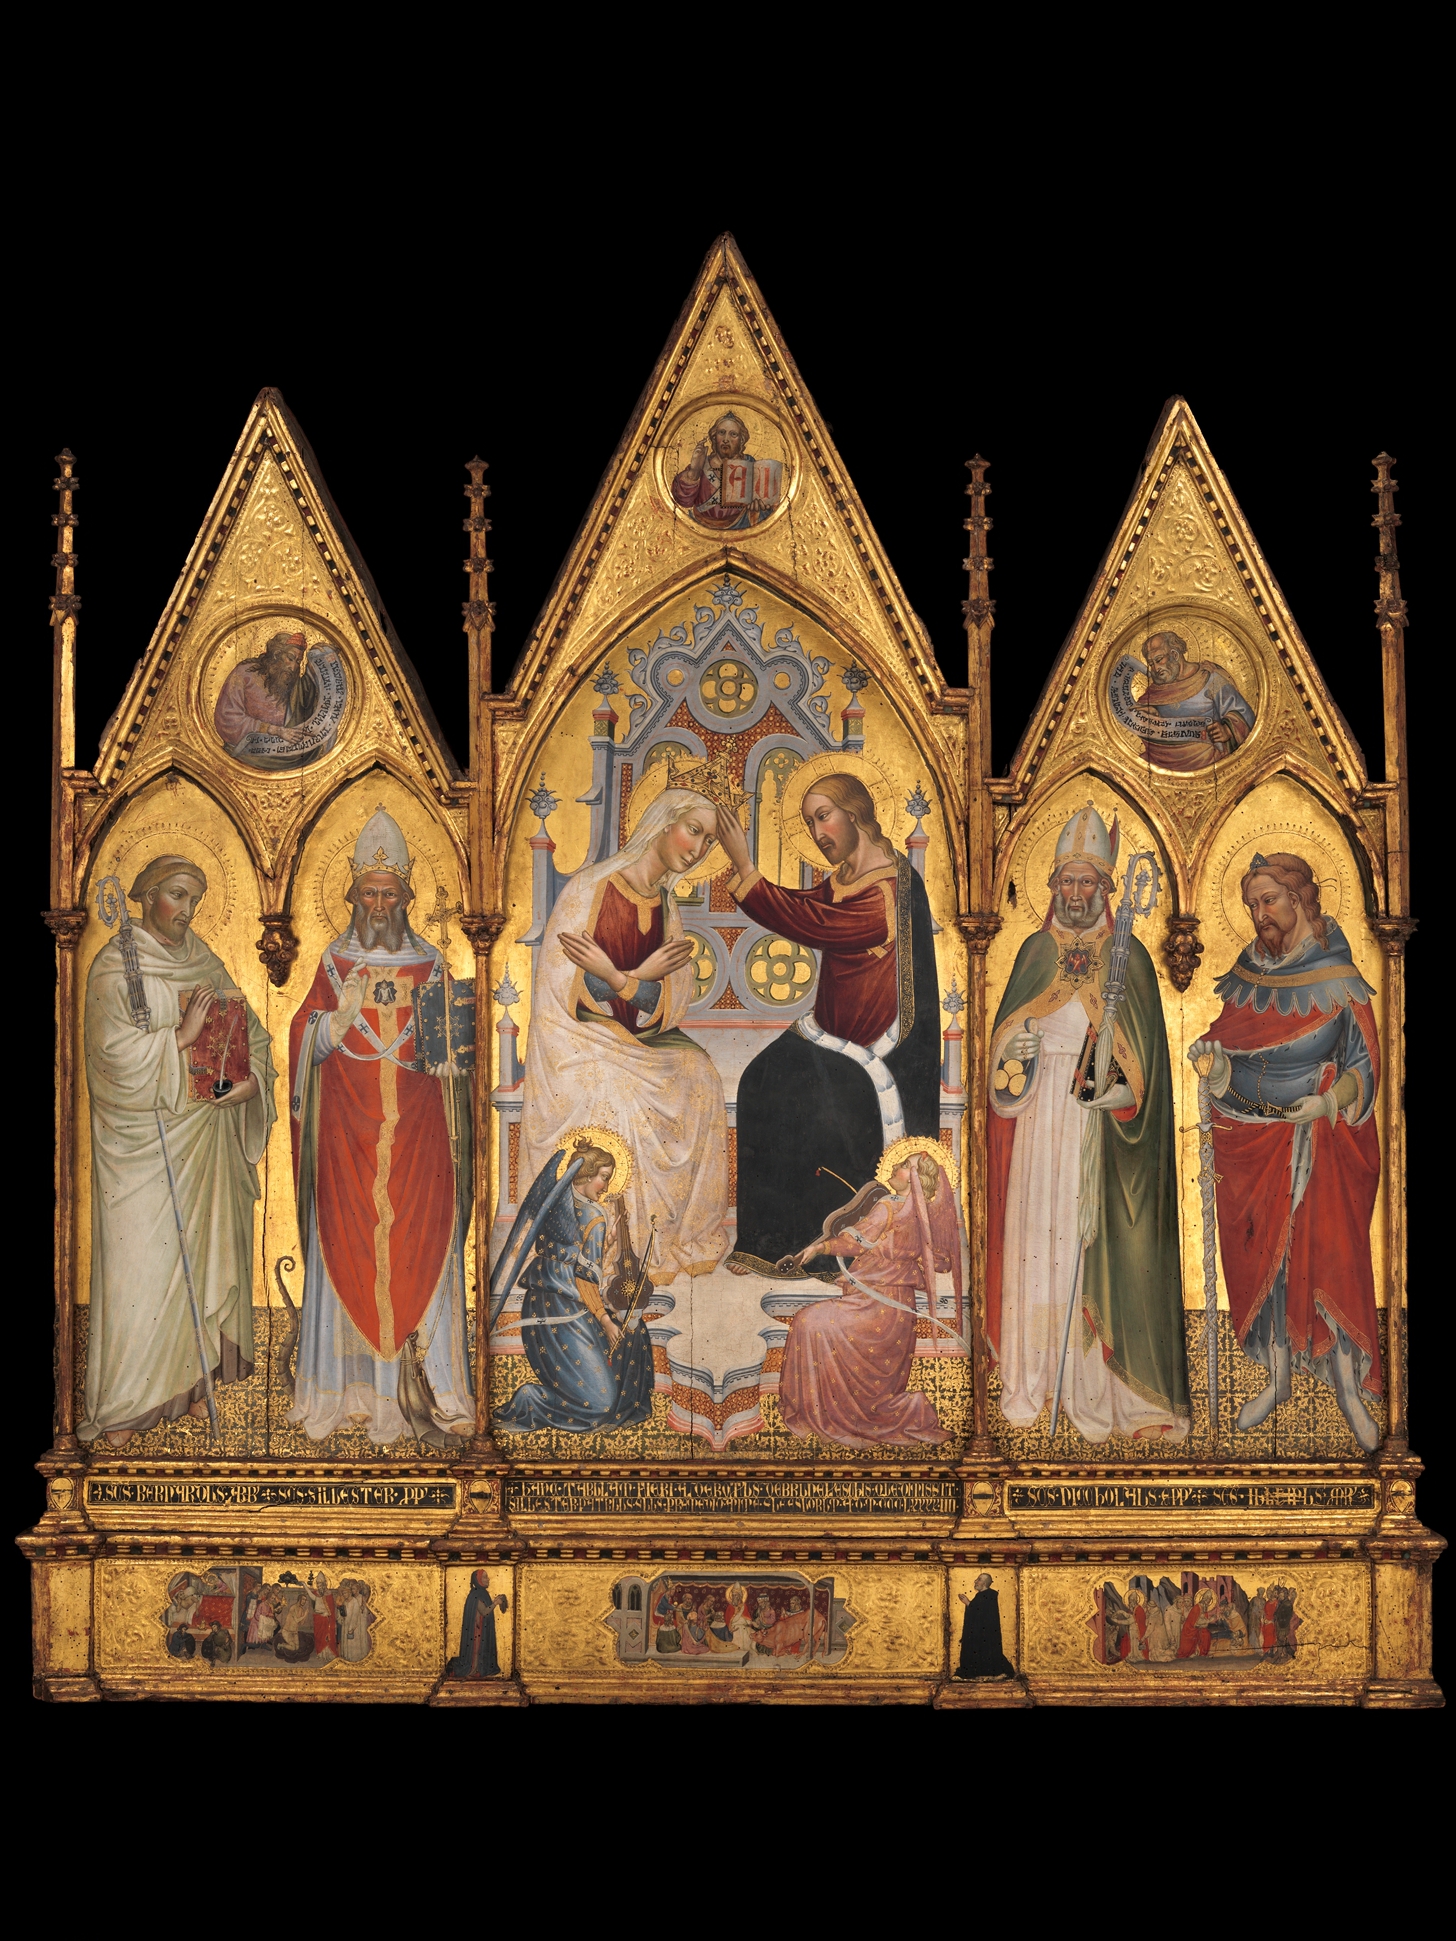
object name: painting, triptych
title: The Coronation of the Virgin, and Saints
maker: giovanni di tano fei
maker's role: artist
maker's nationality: italian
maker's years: 1384-1405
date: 1394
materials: gold leaf, paint, wood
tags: angels,christ,virgin mary,saints,coronation of the virgin